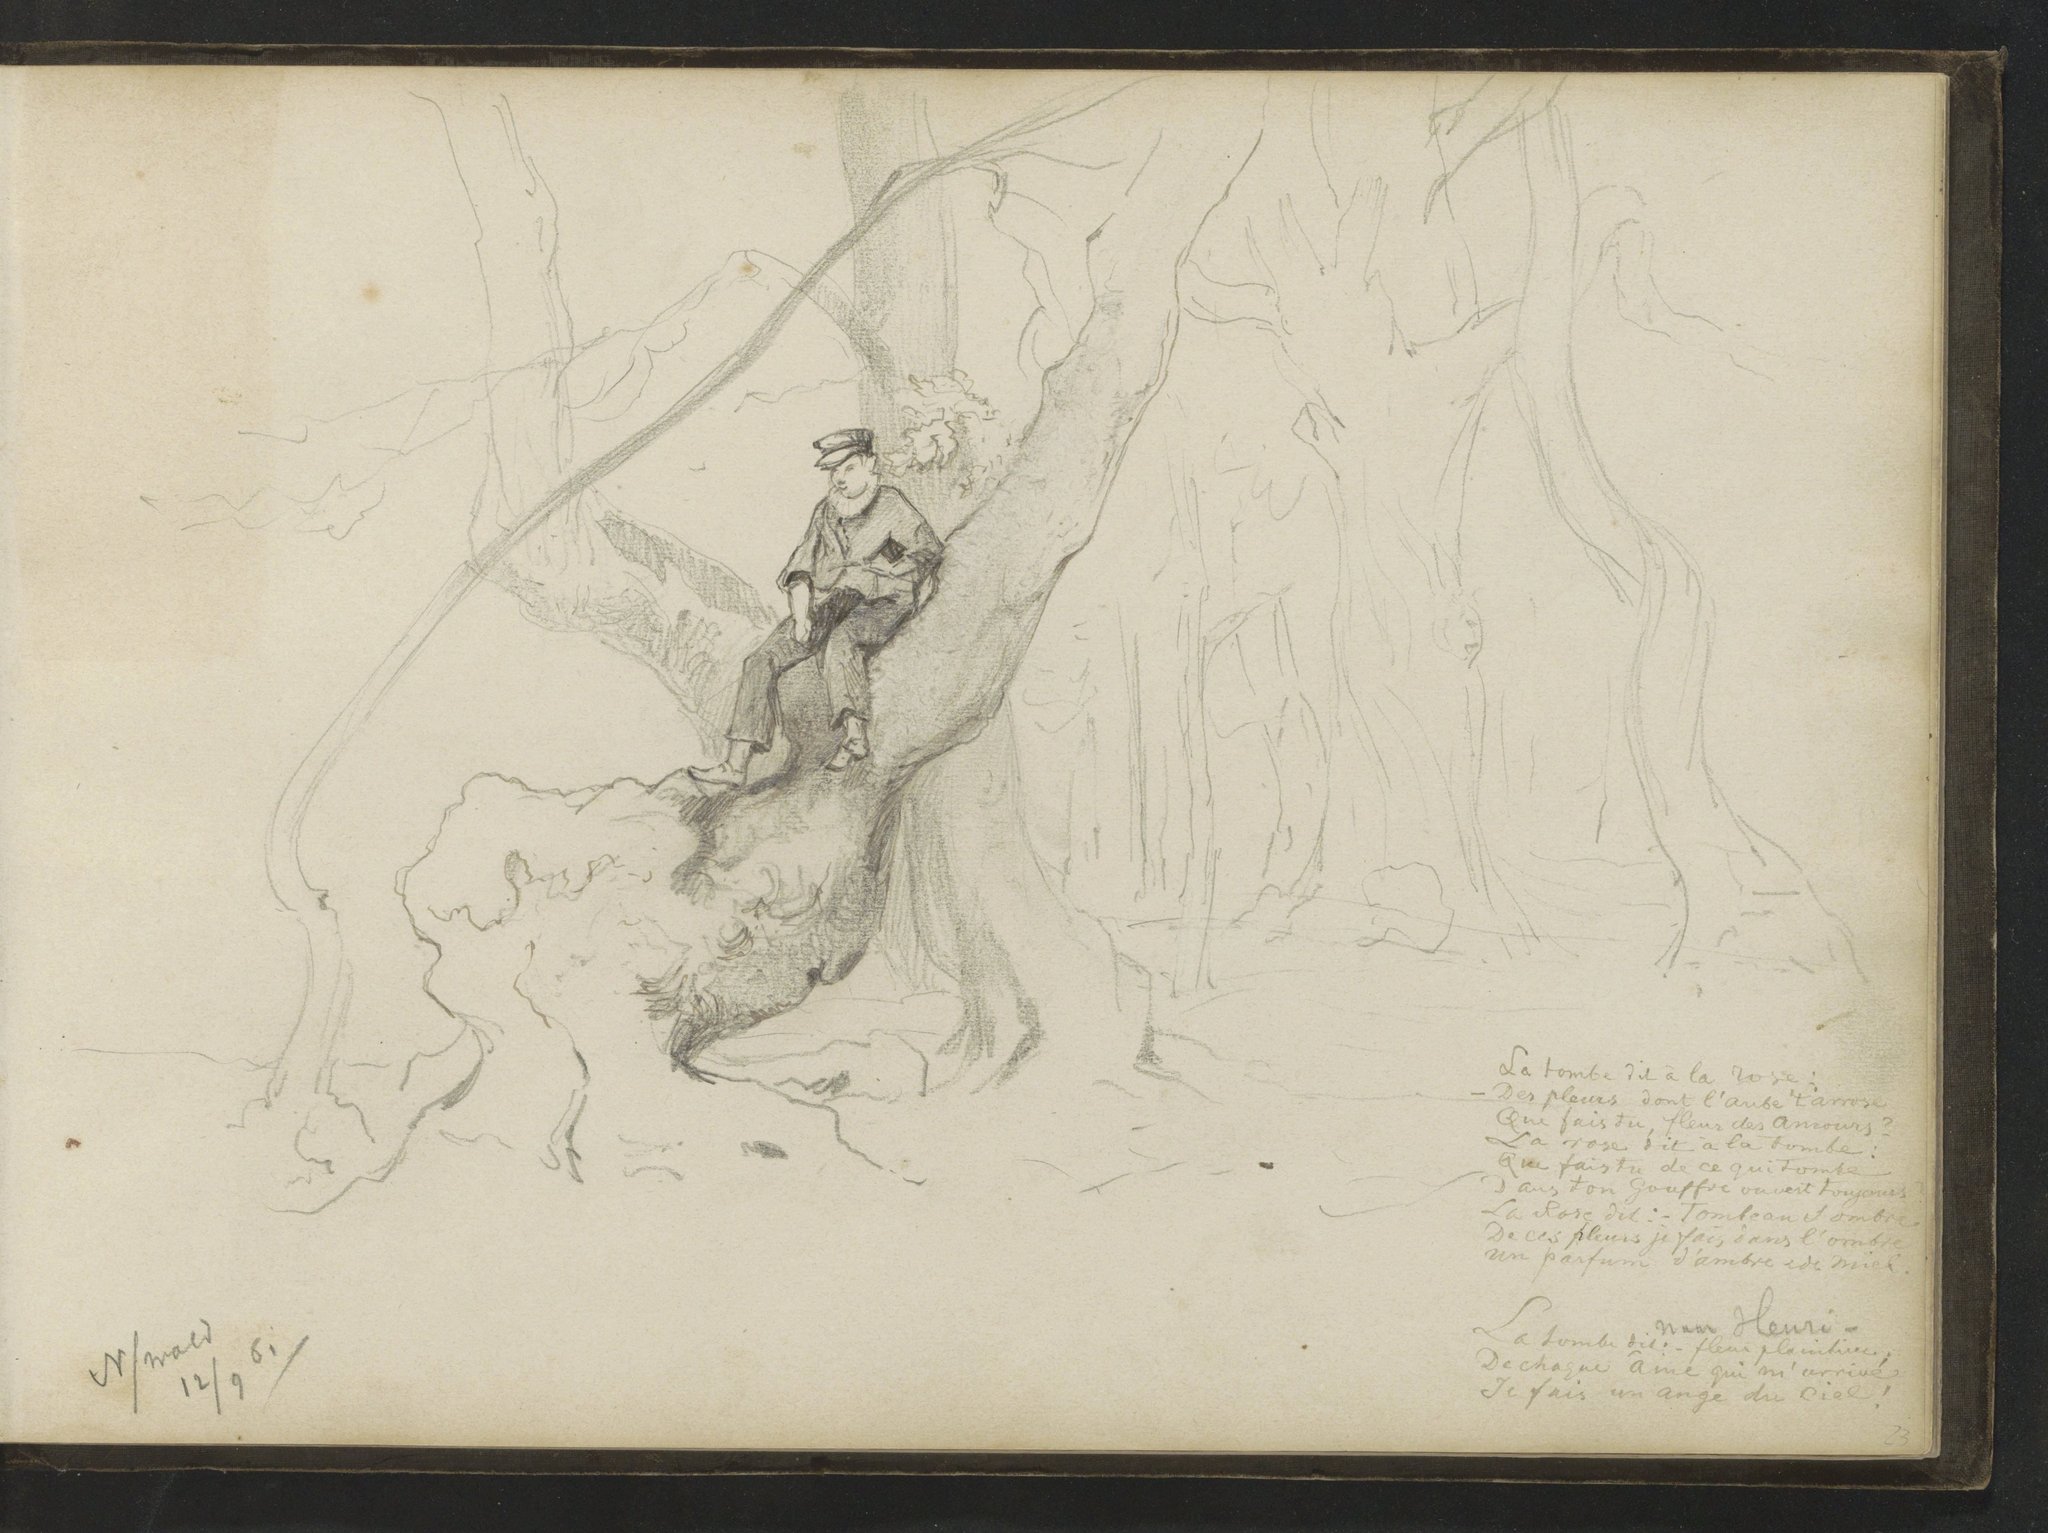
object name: sketchbook leaf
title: Zoon Henri zittend op de stam van een boom in Niederwald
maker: johannes tavenraat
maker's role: draughtsman, painter, print maker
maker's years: 1809-1881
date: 1809-1861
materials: ink, paper, pencil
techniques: pen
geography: niederwald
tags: sitting figure, forest, wood, trees: beech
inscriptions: date and inscription: ‘N/wald/ 12/9 61/ naar Henri’, annotation: ‘[...]’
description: Blad 23 recto uit een schetsboek met 57 bladen.